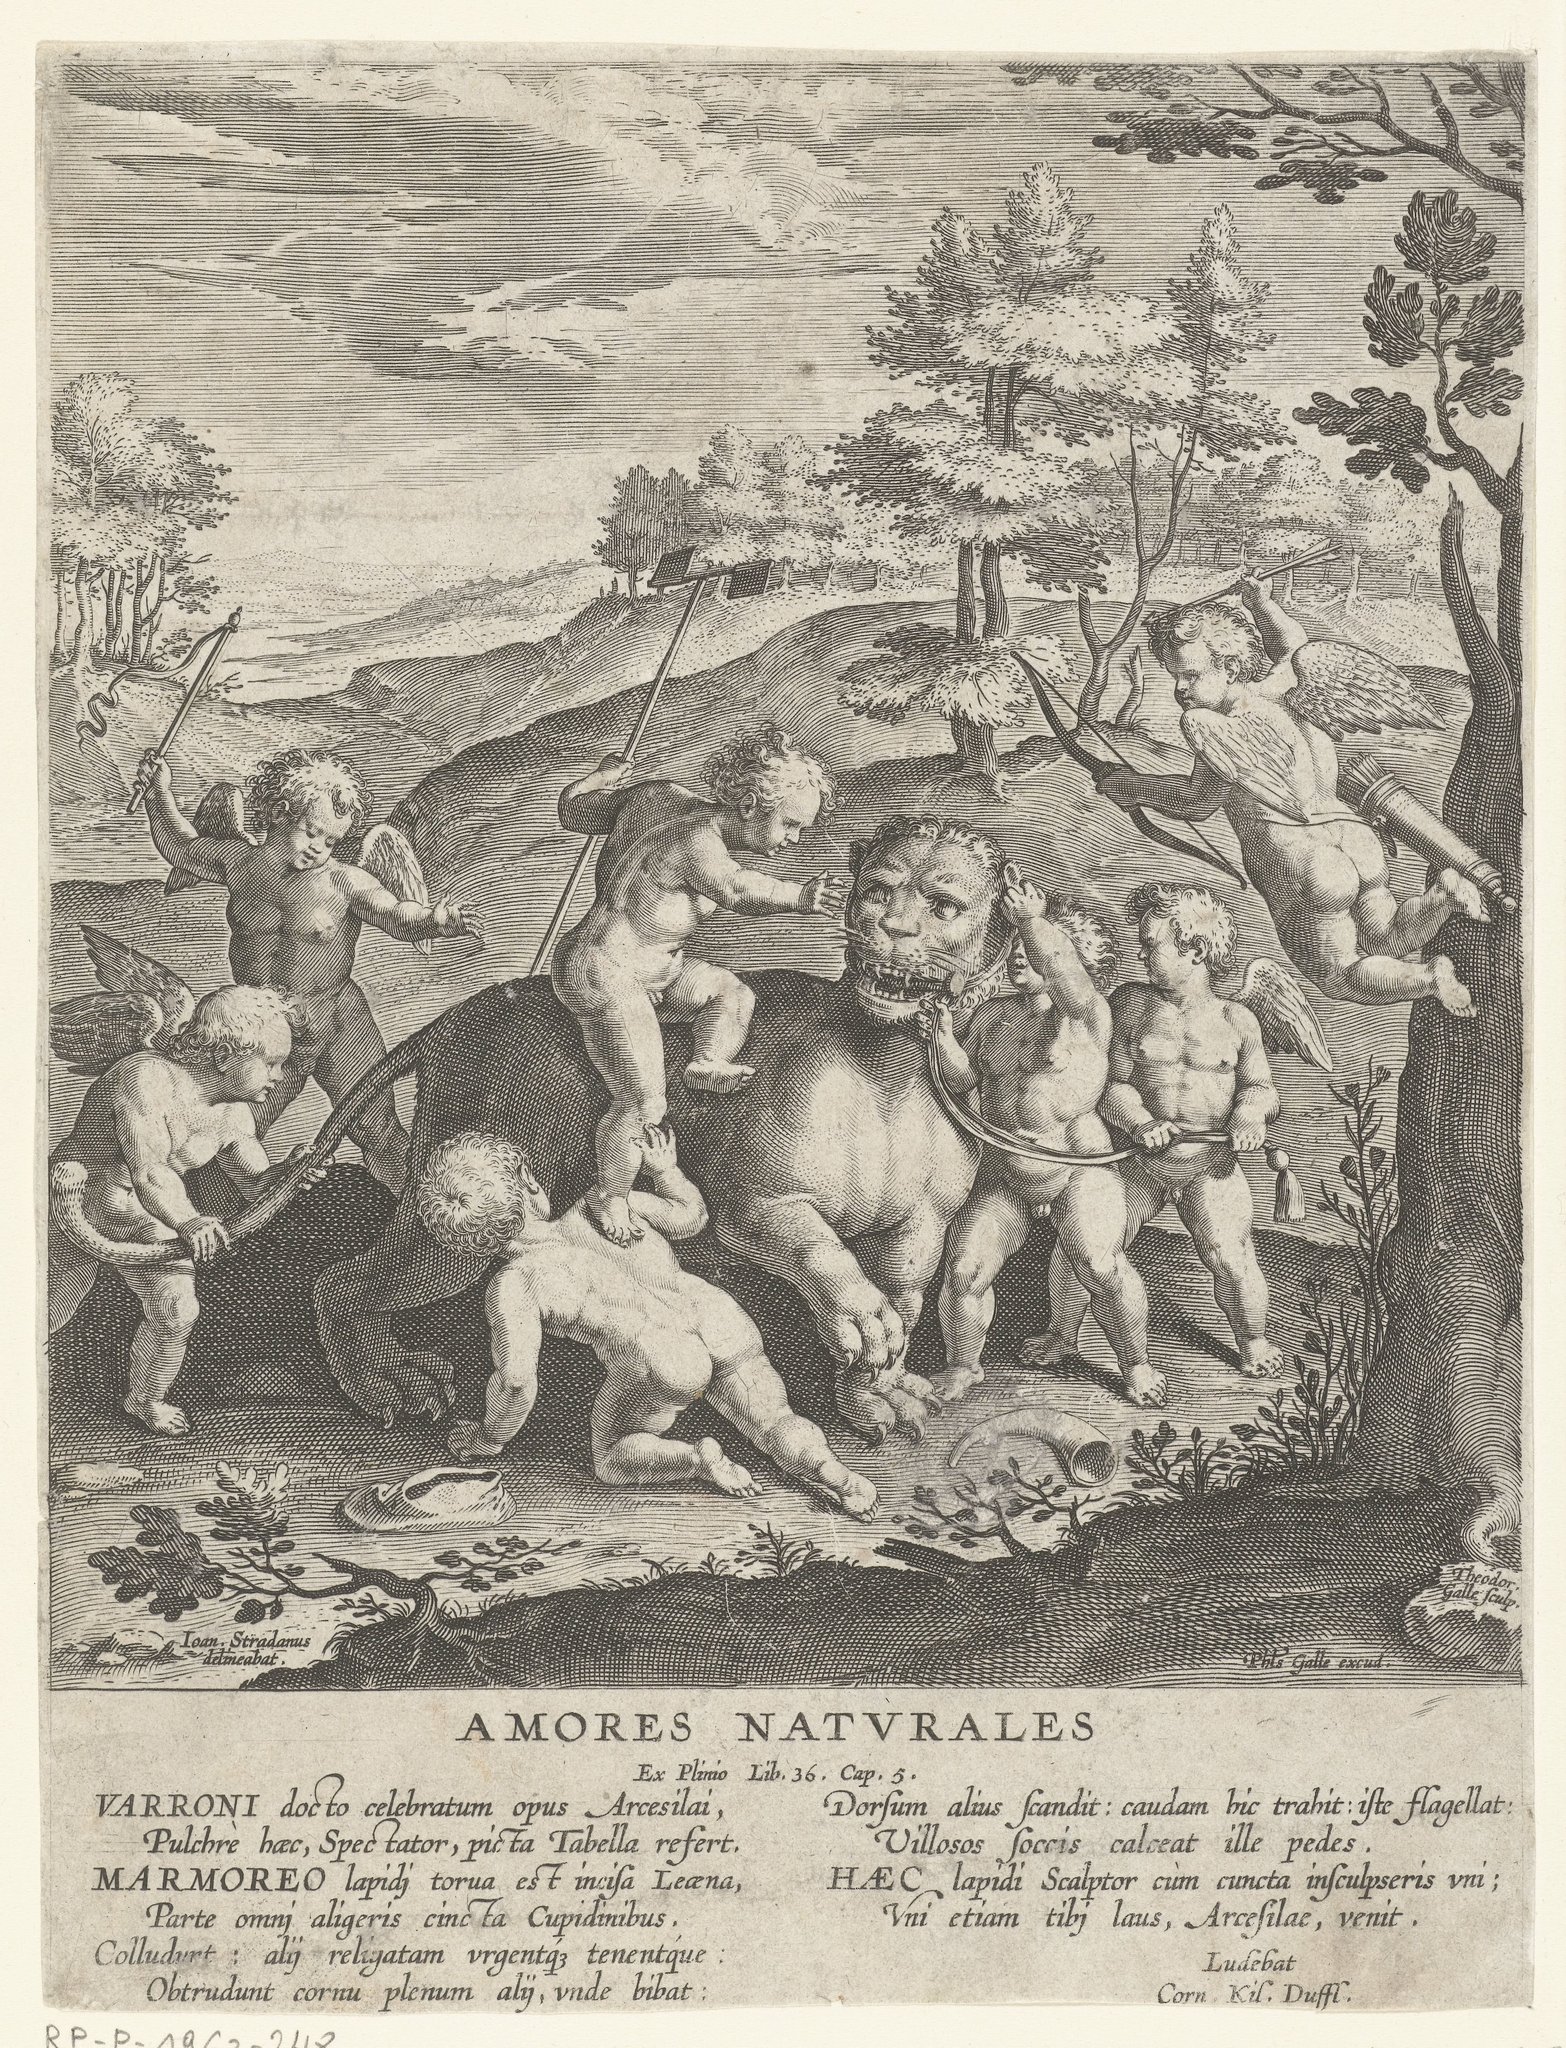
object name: print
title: Amores Naturales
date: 1581-1612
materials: paper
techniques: engraving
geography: antwerp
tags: beasts of prey, predatory animals: lion, 'omnia vincit amor', love the conqueror, love triumphant, cupids: 'amores', 'amoretti', 'putti'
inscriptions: collector's mark: Lugt 2228, collector's mark: Lugt 2760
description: Zes putti muilkorven een leeuw. Cupido vliegt met pijl en boog naar hen toe. Ze bewijzen de kracht van de aardse liefde. De prent heeft een Latijns onderschrift.